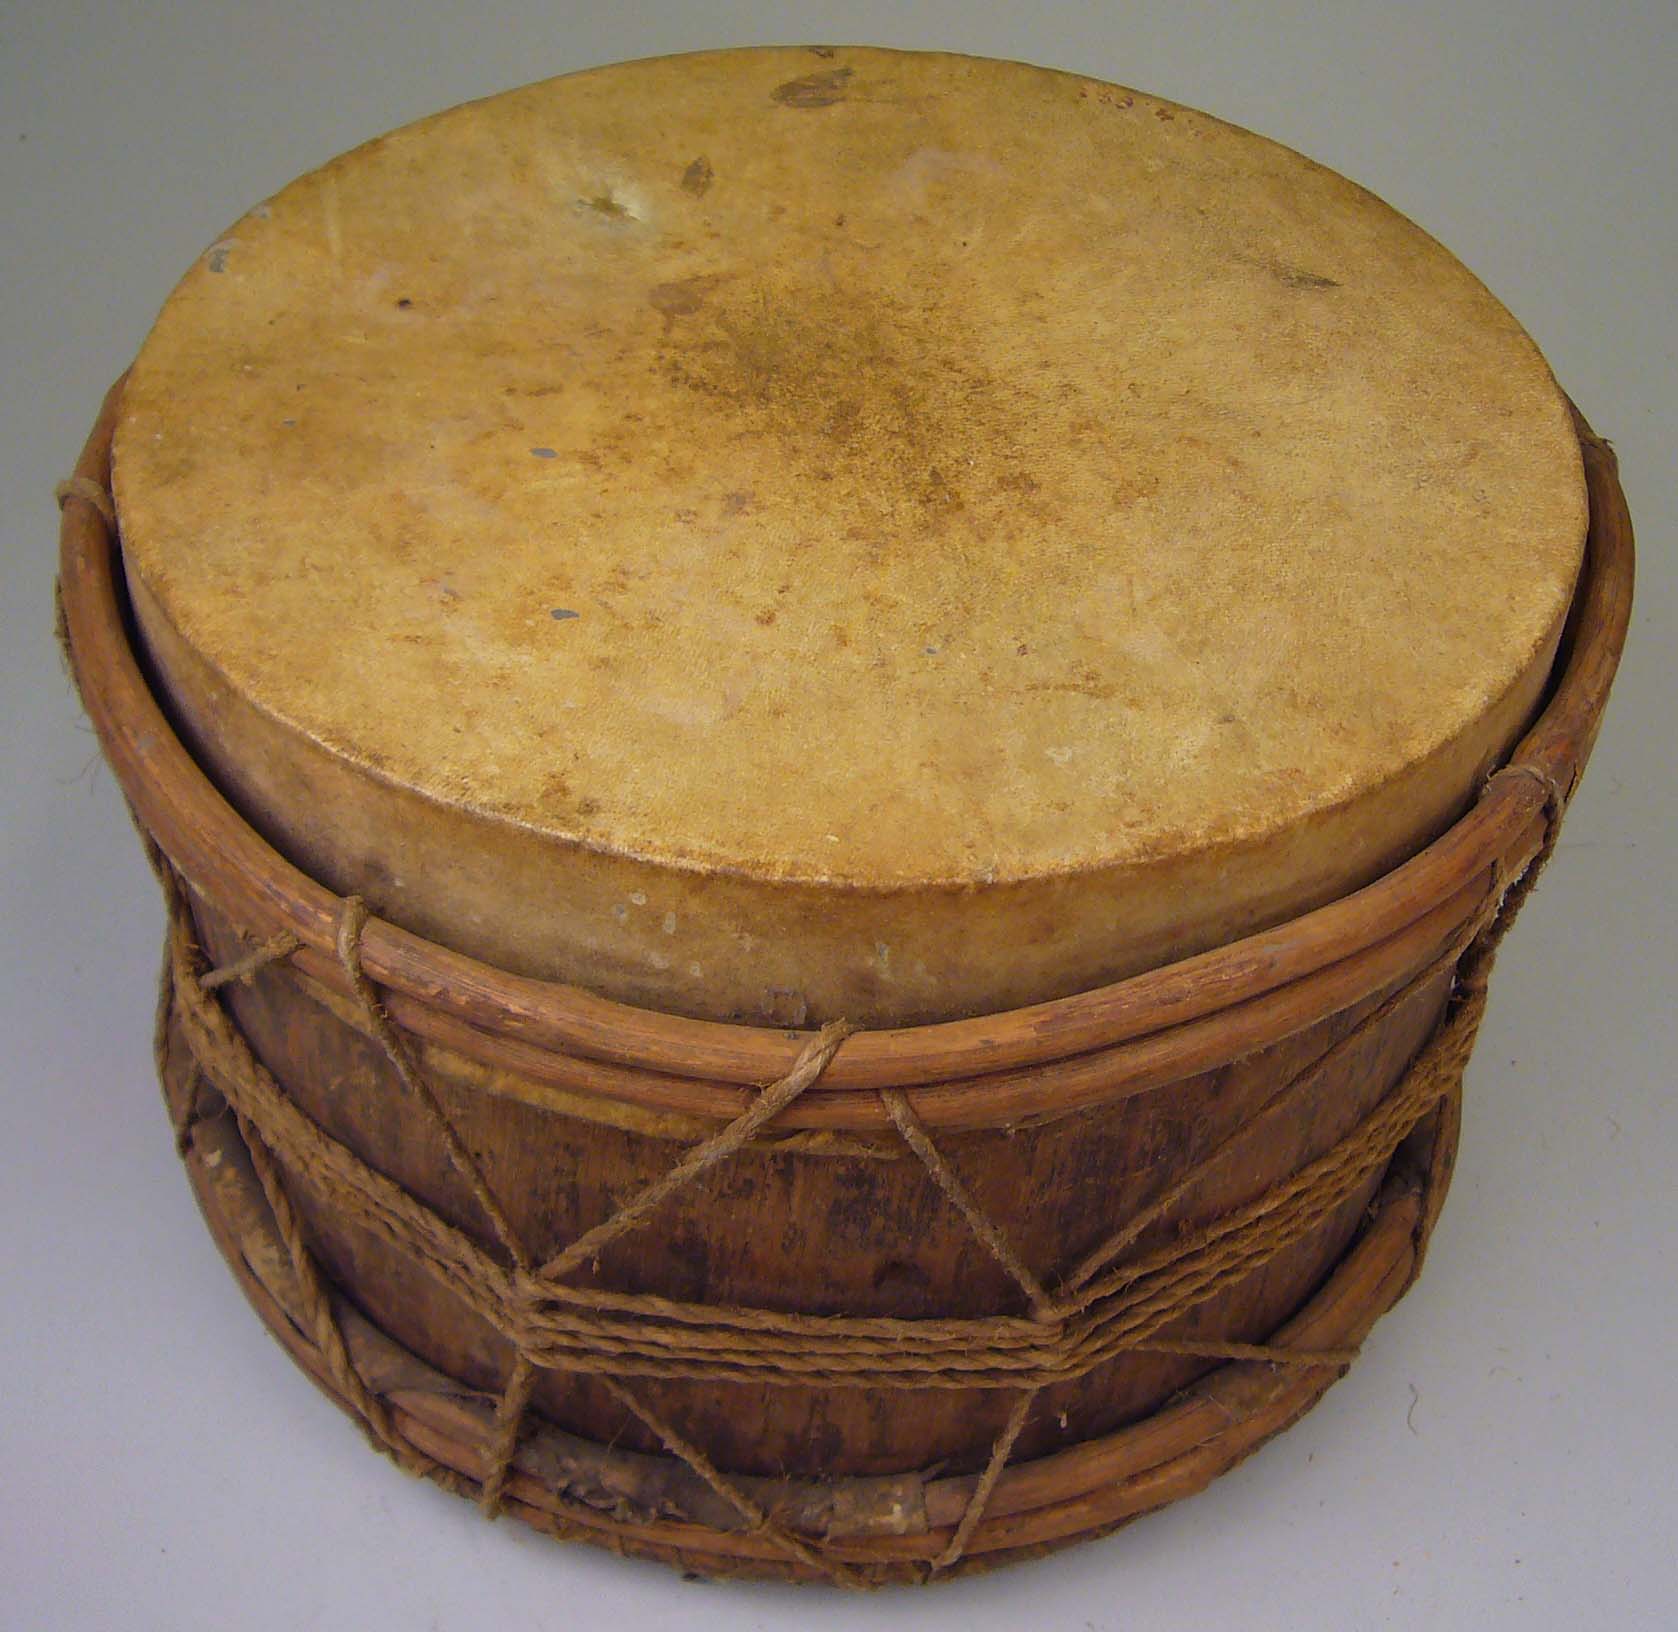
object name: drum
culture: south american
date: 1867-1900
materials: skin, wood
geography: guyana